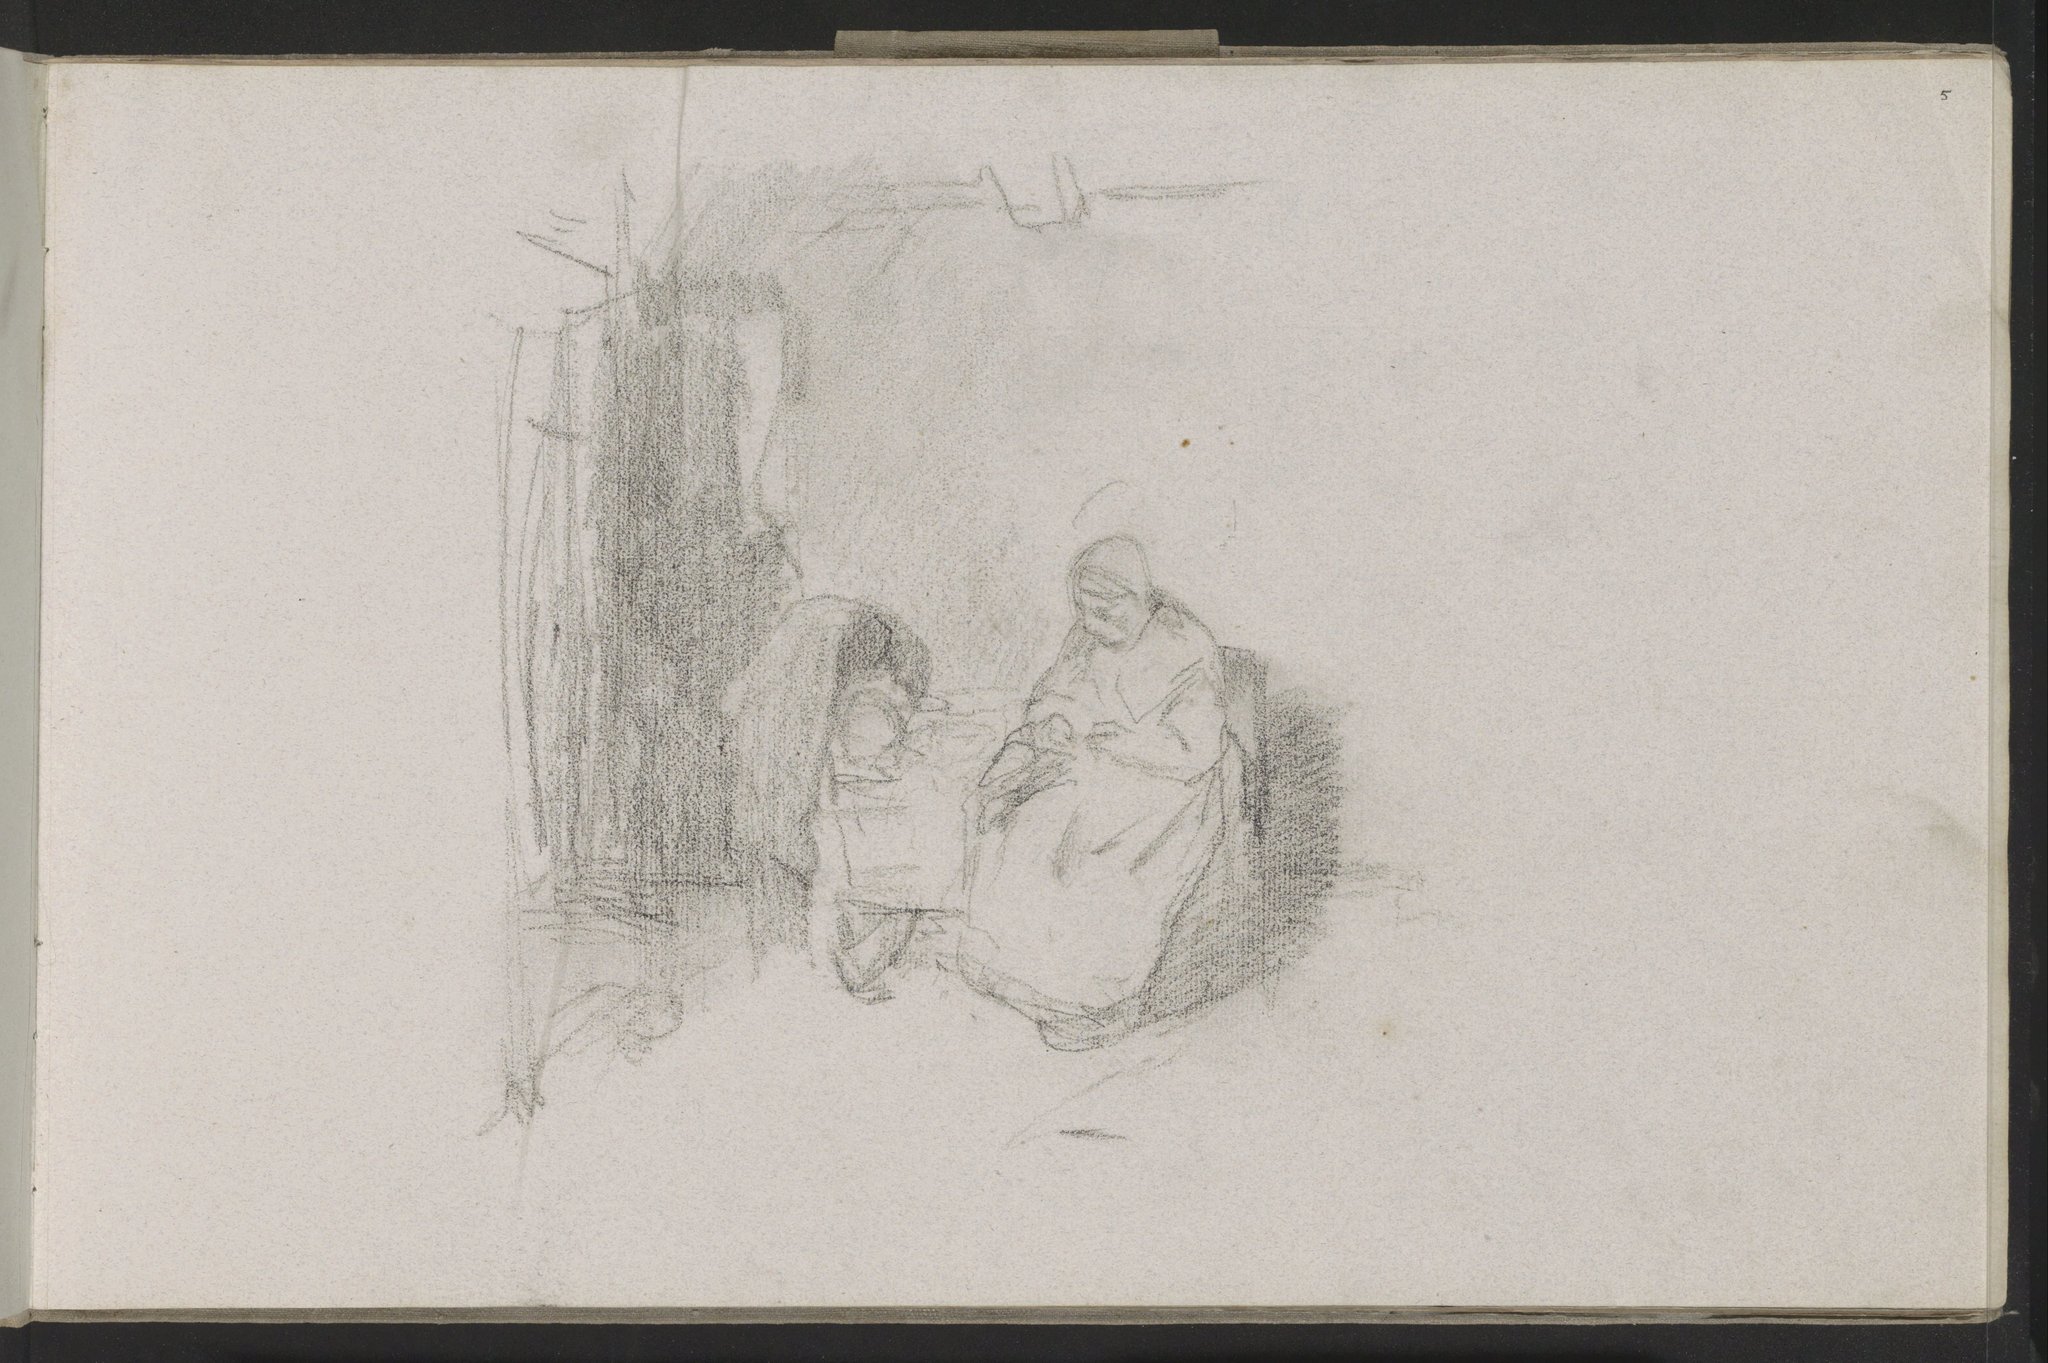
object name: sketchbook leaf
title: Naaiende vrouw zittend naast een wieg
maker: albert neuhuys (1844-1914)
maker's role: draughtsman, painter, print maker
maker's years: 1844-1914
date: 1854-1914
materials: charcoal, paper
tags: sitting figure, adult woman, interior of the house, cradle, crib, home sewing; repair of clothes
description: Blad 5 recto uit een schetsboek met 51 bladen.